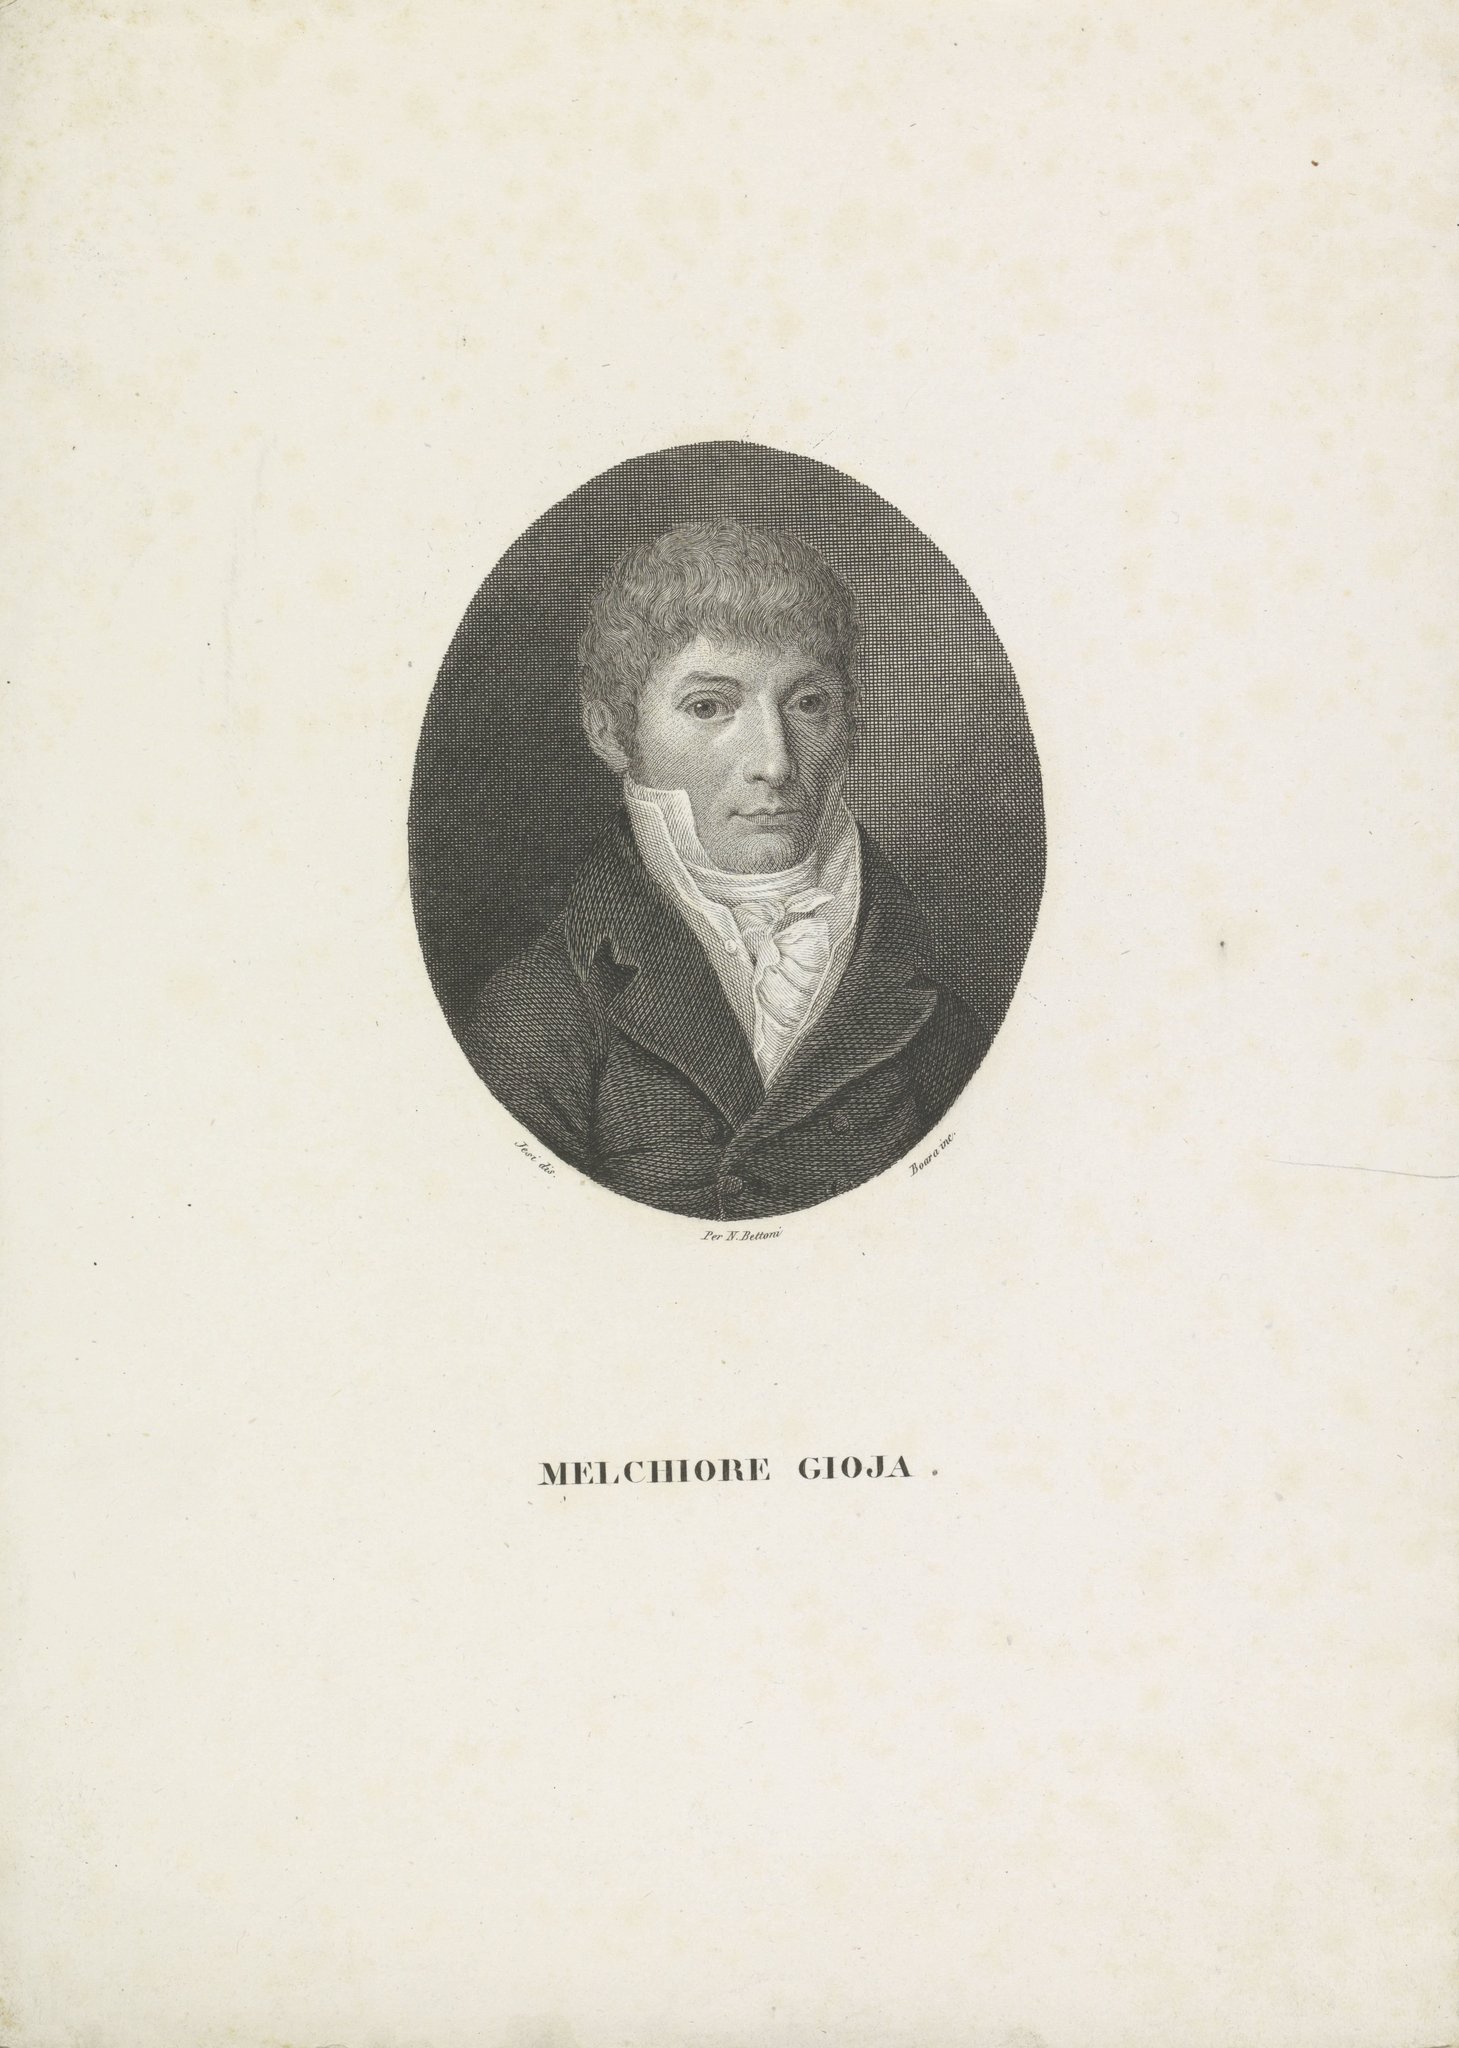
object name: print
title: Portret van schrijver Melchiorre Gioia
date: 1800-1899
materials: paper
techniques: engraving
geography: italy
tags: historical persons, writer, poet, author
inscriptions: collector's mark: Lugt 2228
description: Deze prent maakt deel uit van een reeks portretprenten van onbekende omvang. De reeks is in meerdere staten uitgegeven. De eerste staat met enkel het portret in ovaal. Een tweede staat met naam van de geportretteerde in holle letters onder de voorstelling. Een derde staat met de naam van de geportretteerde in gevulde letters onder de voorstelling. En een vierde staat met een rechthoekig kader rondom het ovale portret.